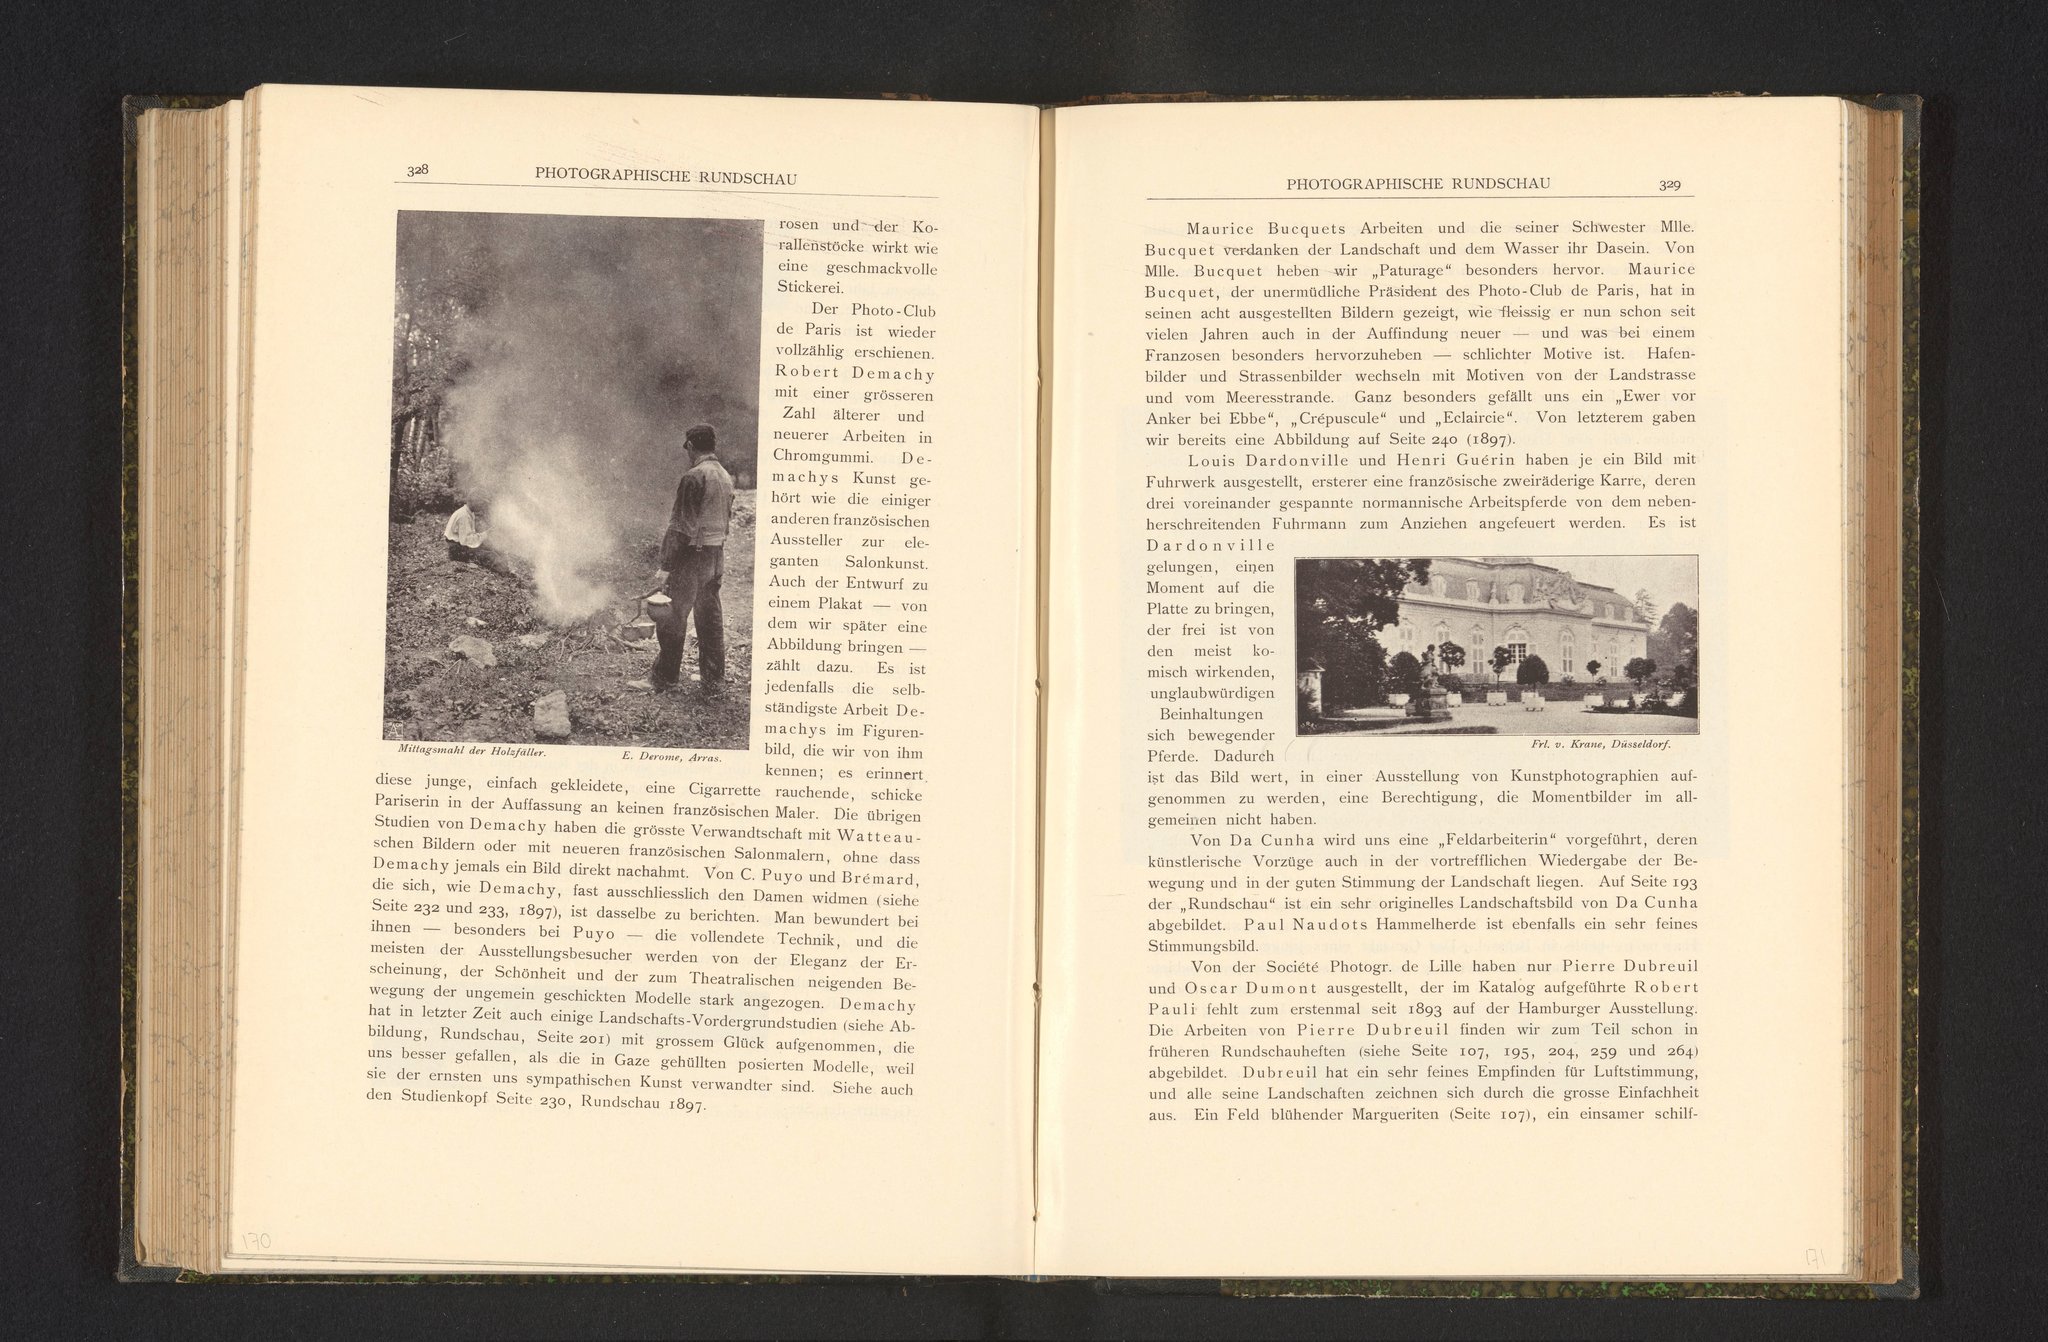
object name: page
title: Gezicht op de façade van een gebouw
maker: anna von krane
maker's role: fotograaf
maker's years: 1853-1937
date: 1893-1898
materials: paper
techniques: autotype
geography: berlin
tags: front façade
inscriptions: monogram: ‘MR&C’